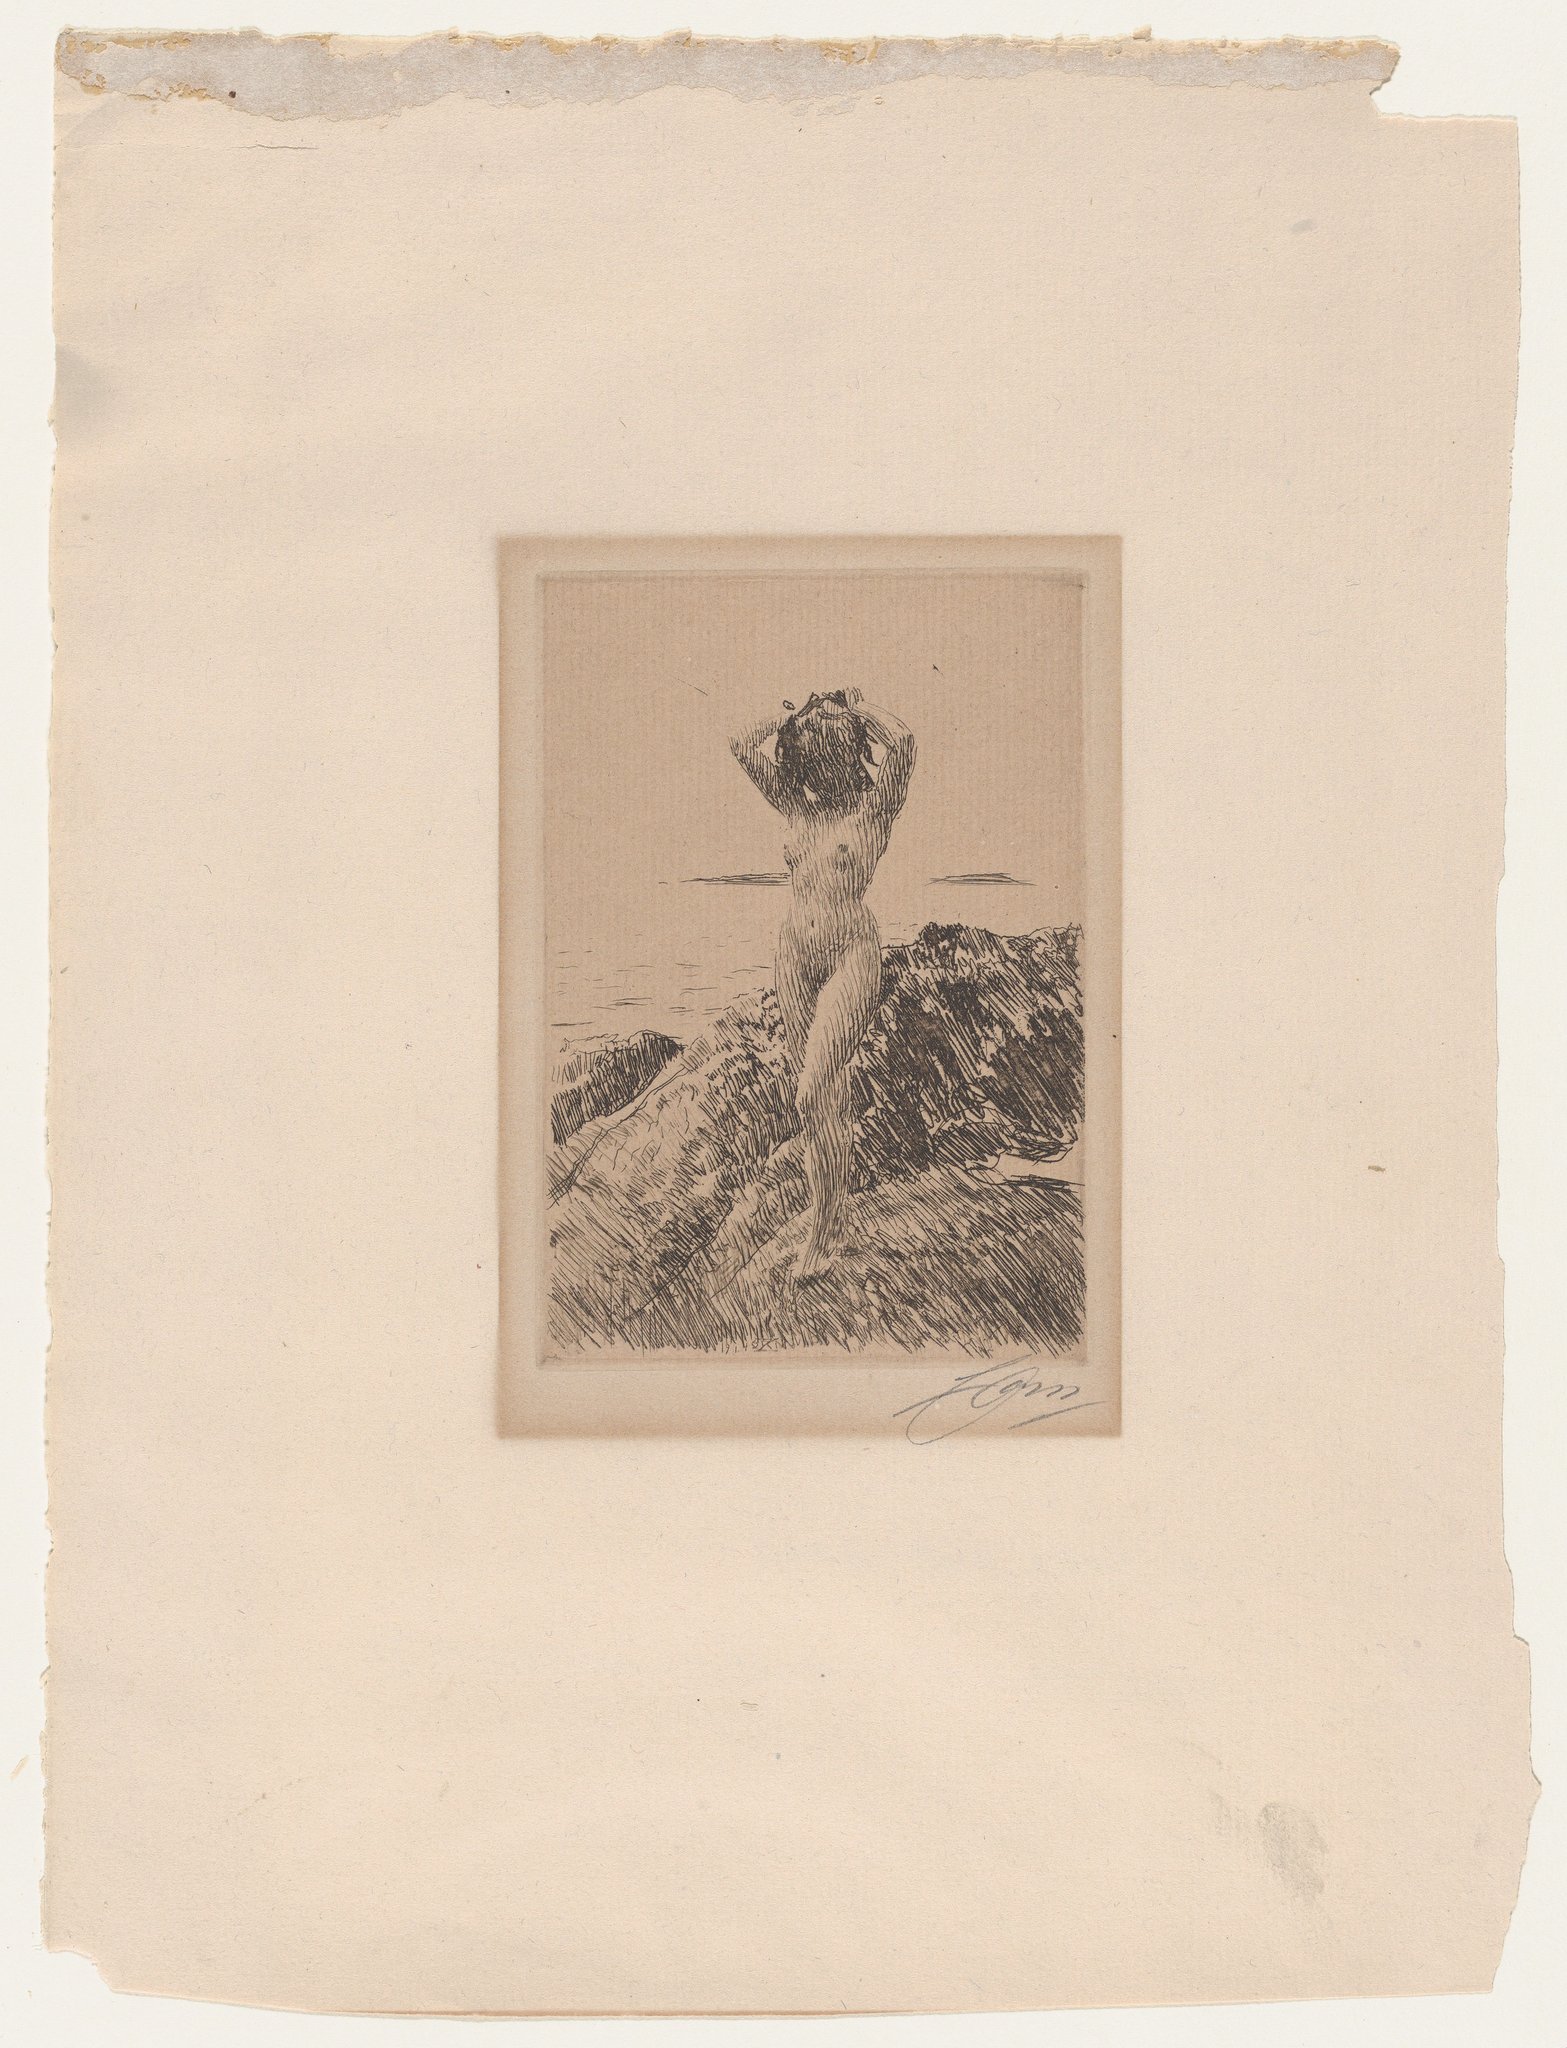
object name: print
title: Hårtång (Seaweed Wreath)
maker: anders zorn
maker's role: artist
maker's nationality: swedish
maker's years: 1860-1920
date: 1914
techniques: etching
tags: female nudes